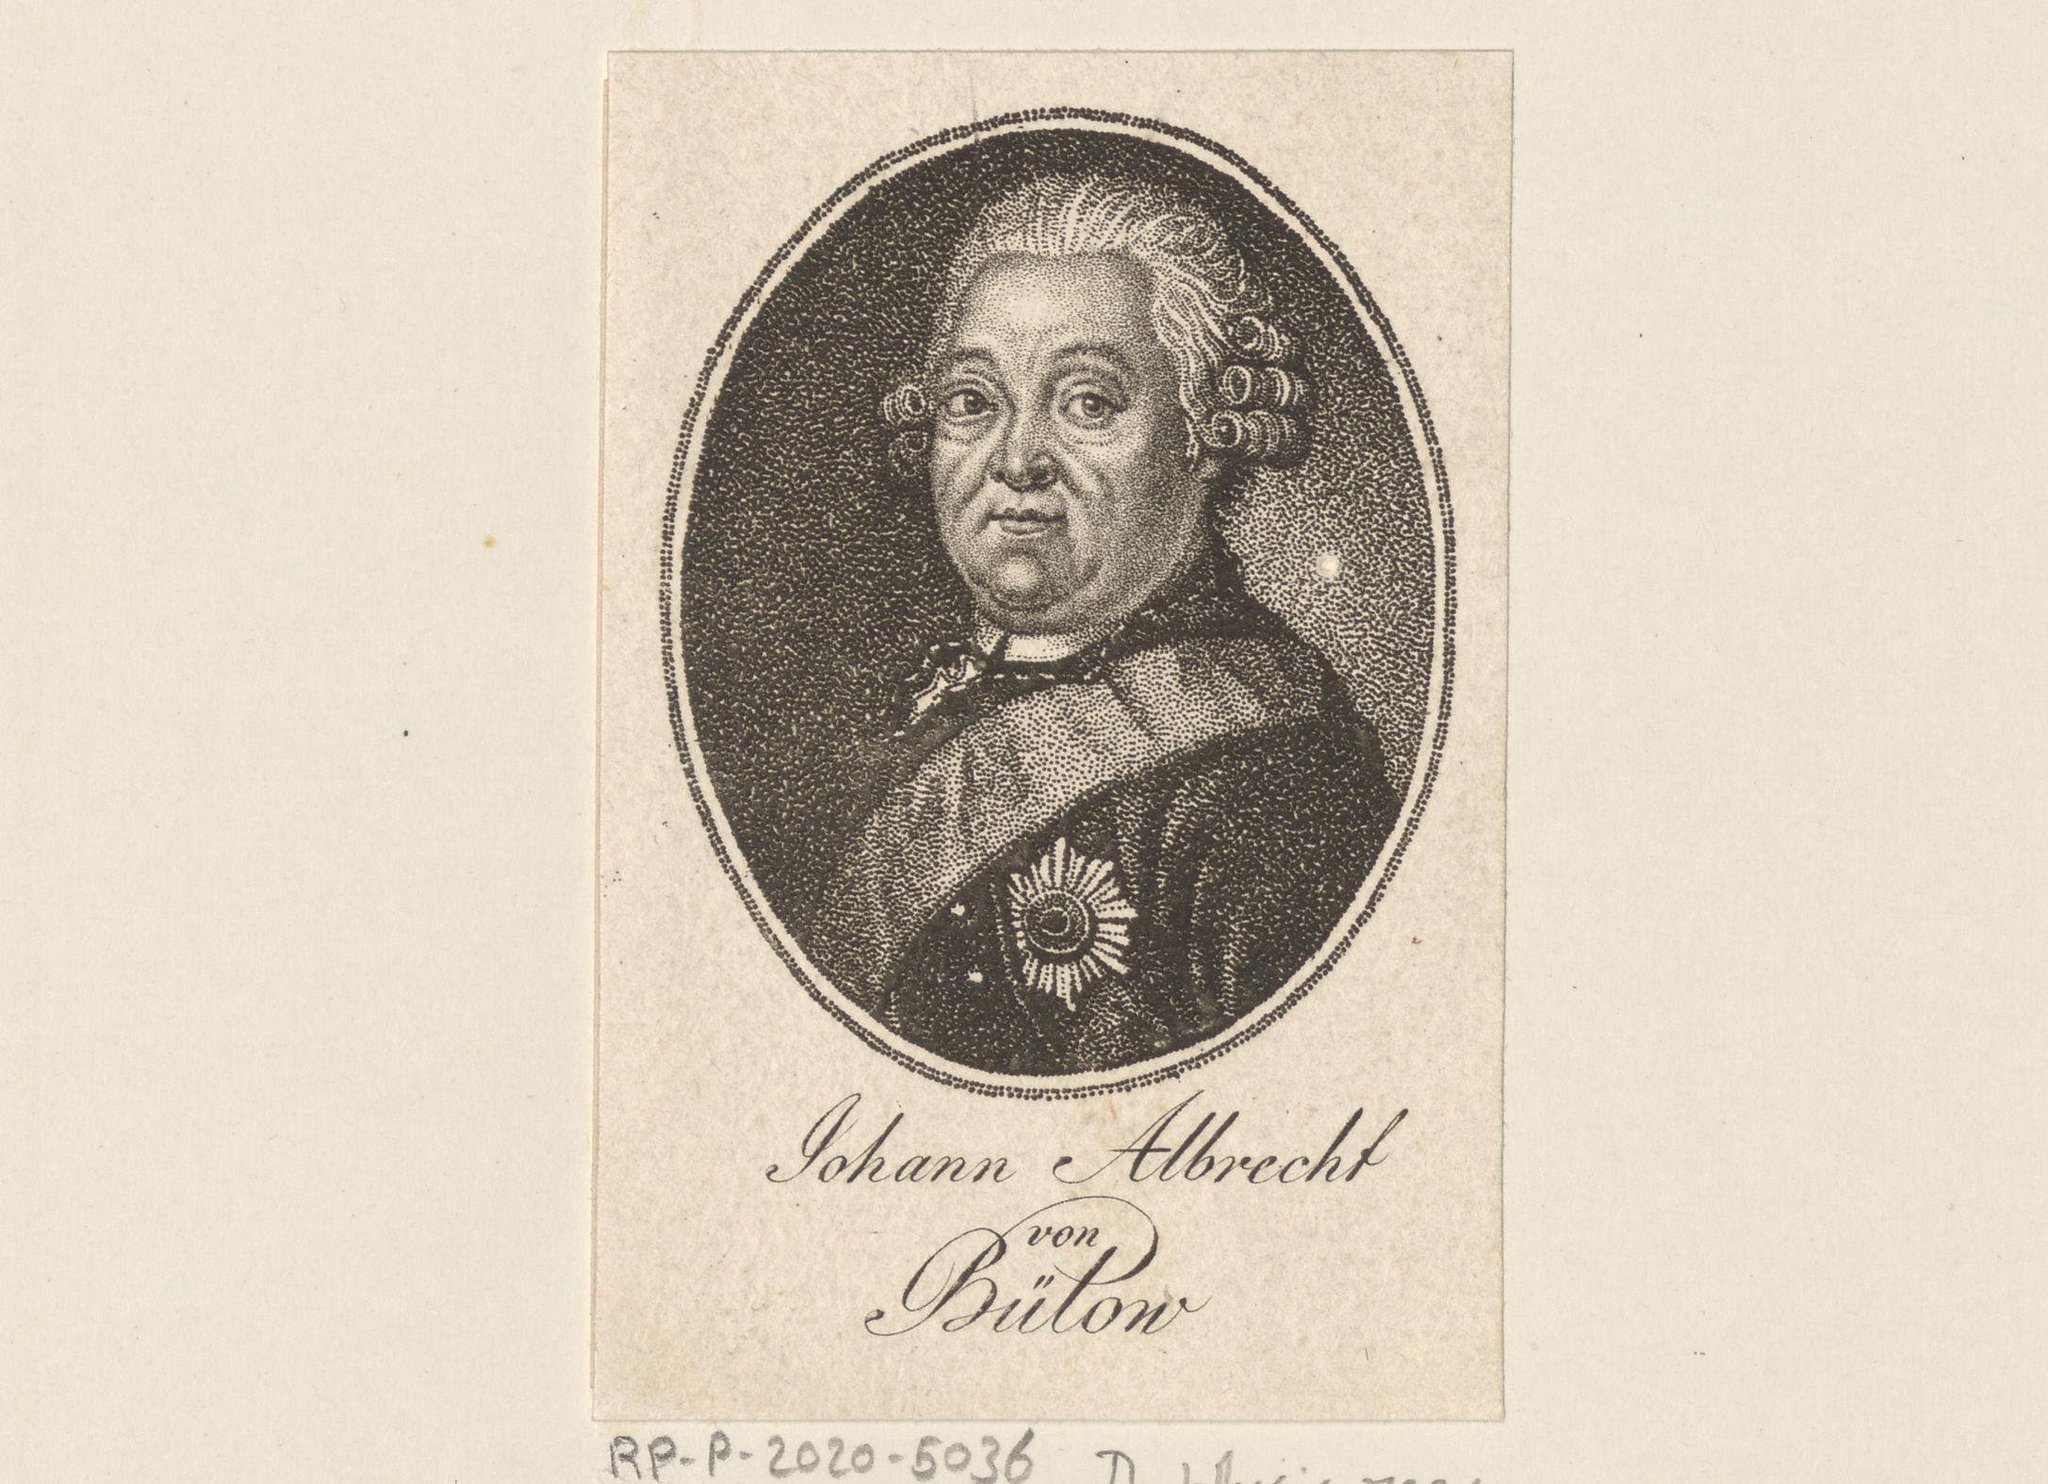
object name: print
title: Portret van Johann Albrecht von Bülow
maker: Anonymous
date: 1750-1799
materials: paper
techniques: engraving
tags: commander-in-chief, general, marshal, historical persons